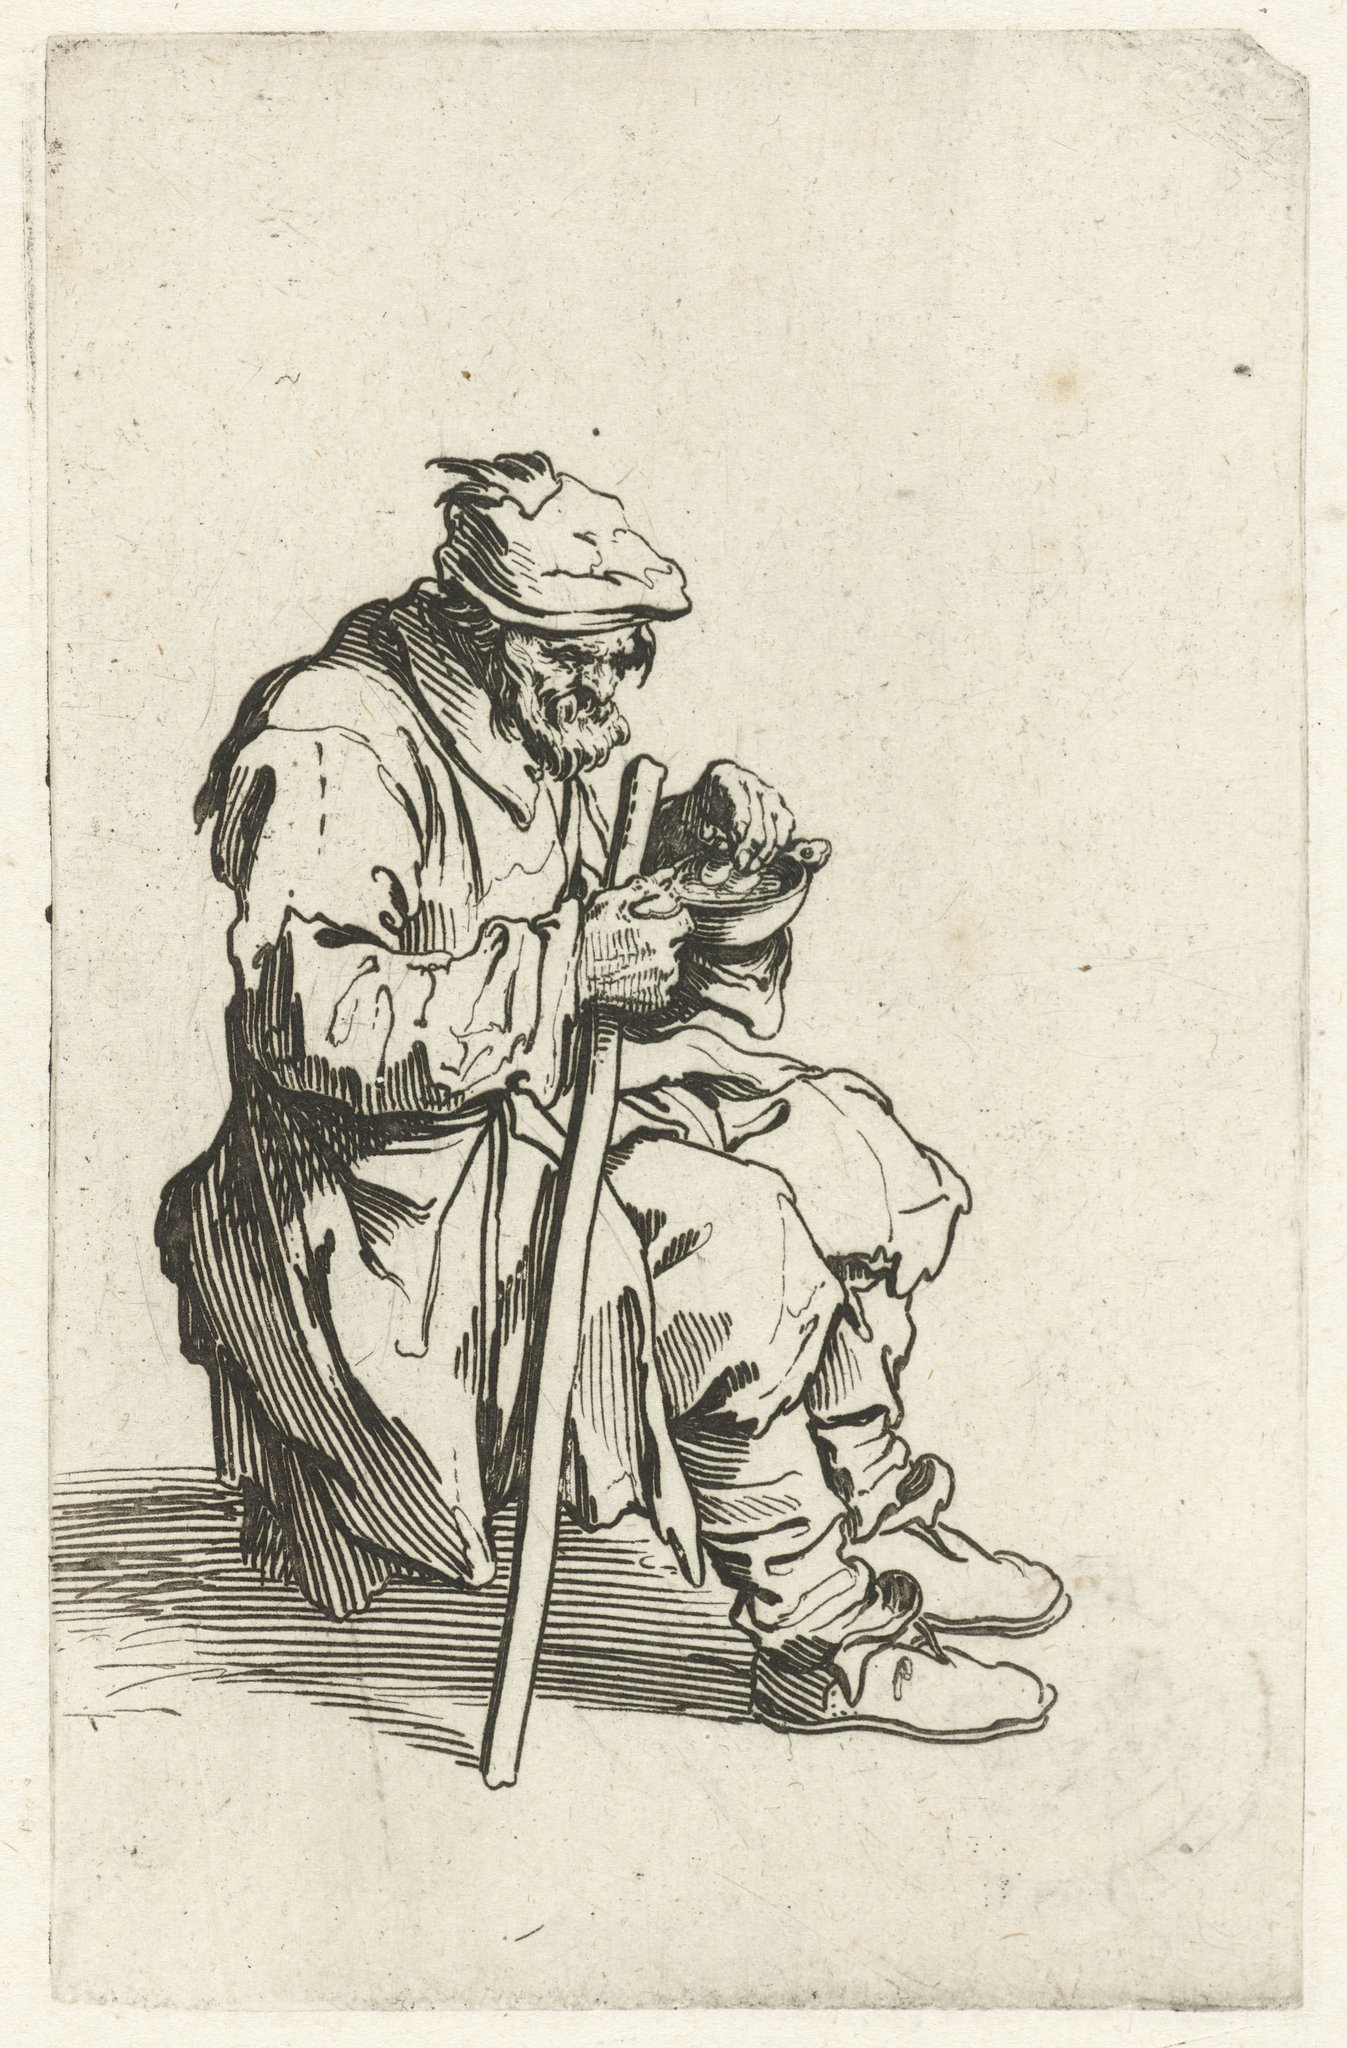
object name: print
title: Zittende bedelaar met een kom en een stok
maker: jacques callot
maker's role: draughtsman, print maker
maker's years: 1592-1635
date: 1622-1623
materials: paper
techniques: etching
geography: nancy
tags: walking-stick, staff, begging bowl, bowl, coin, beggar, eating, counting, calculating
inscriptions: collector's mark: Lugt 240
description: Man, gekleed in lompen, op de rechterzijde gezien, zittend, in de rechterhand een stok en een kom of bedelnap, waaruit hij met de linkerhand iets te eten pakt (of telt hij wellicht zijn geld?). Deze prent is onderdeel van een serie van 25 prenten met bedelaars en zwervers, zoals Callot die waarschijnlijk in Italië heeft gezien.